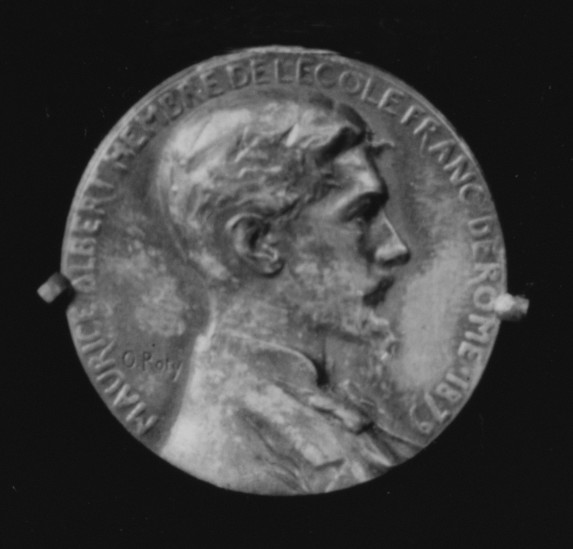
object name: jeton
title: Maurice Albert, Member of the French School at Rome, 1879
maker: louis-oscar roty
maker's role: artist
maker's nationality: french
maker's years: 1846-1911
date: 1879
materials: silver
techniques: casting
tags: men,portraits,profiles